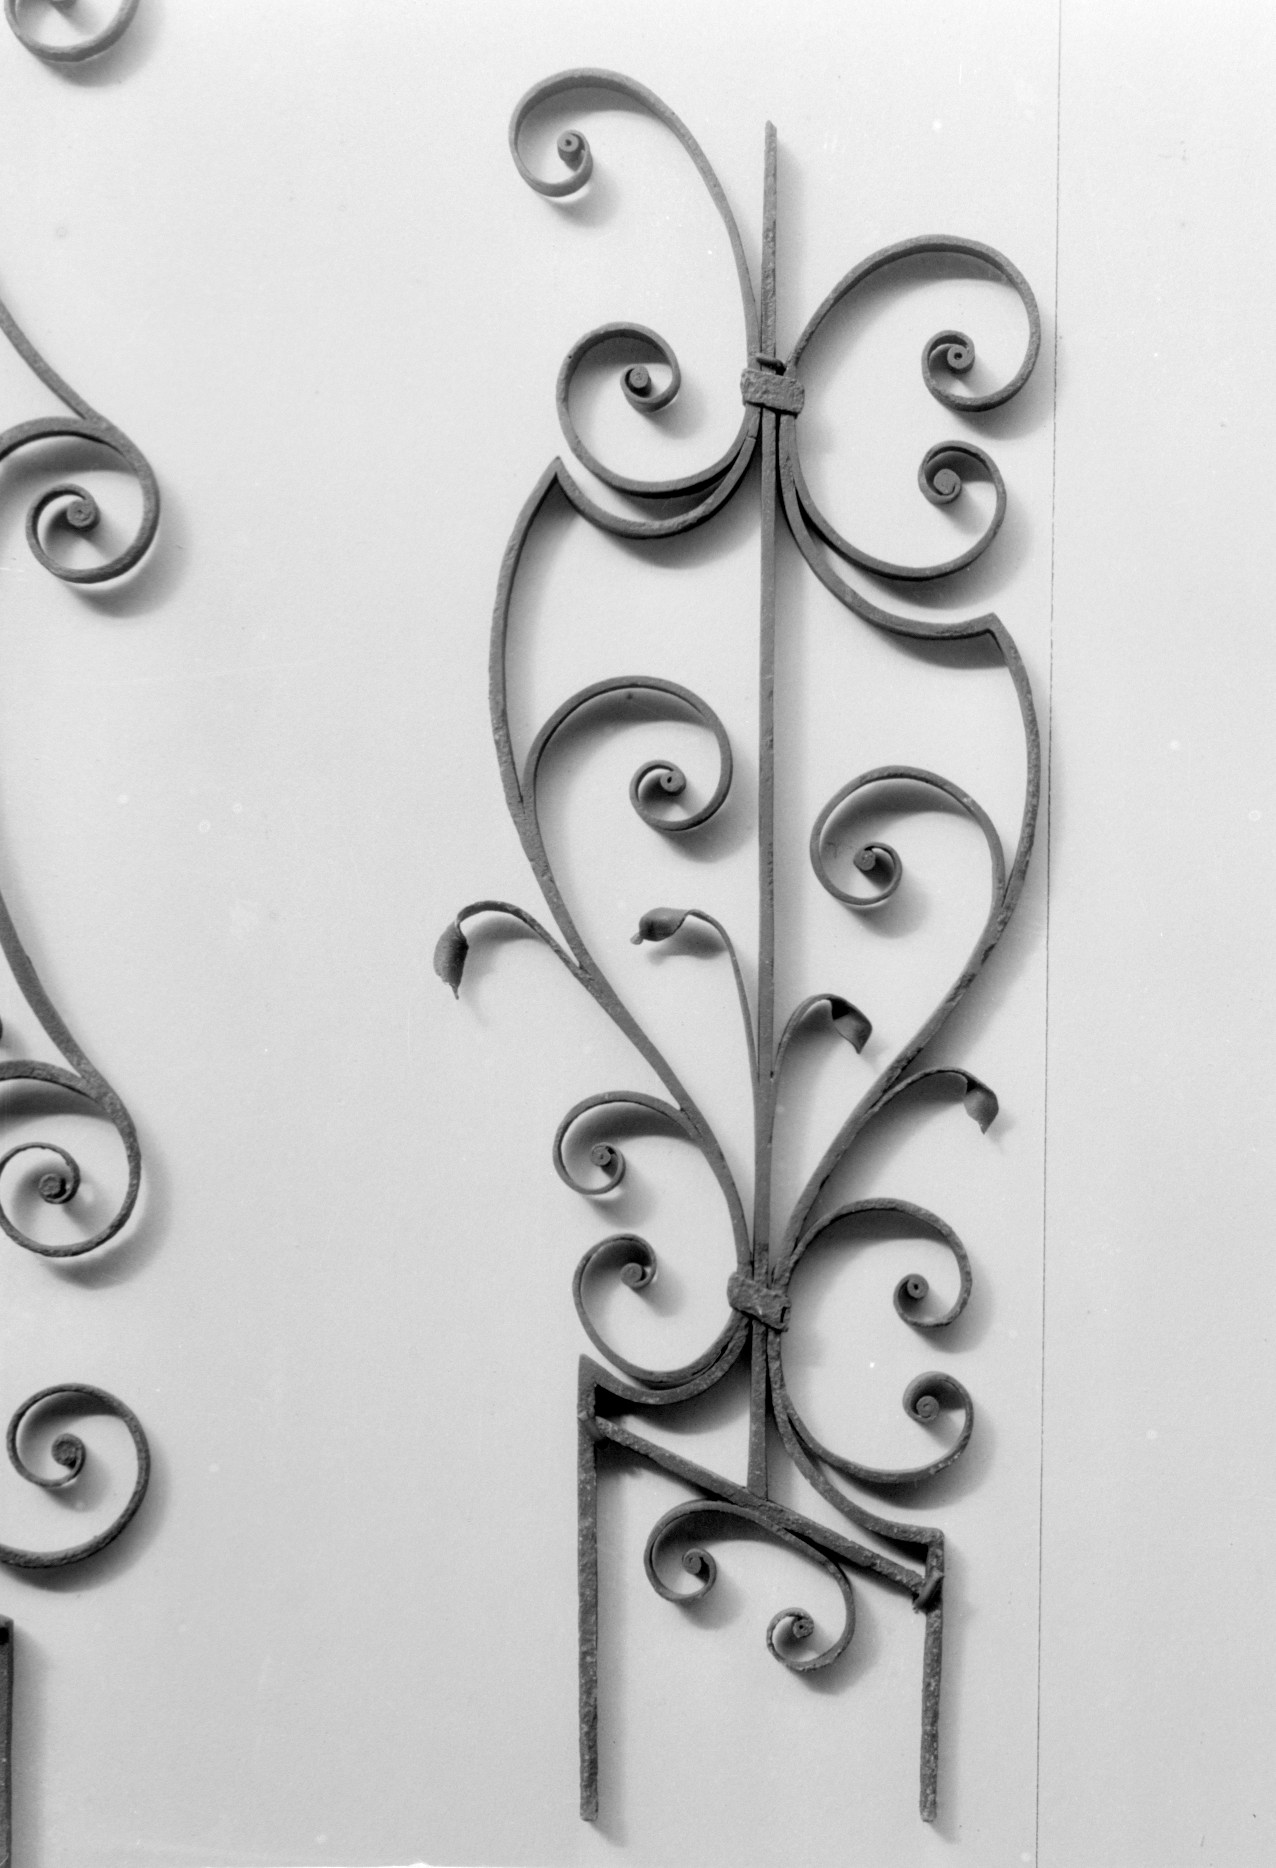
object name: baluster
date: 1750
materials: iron